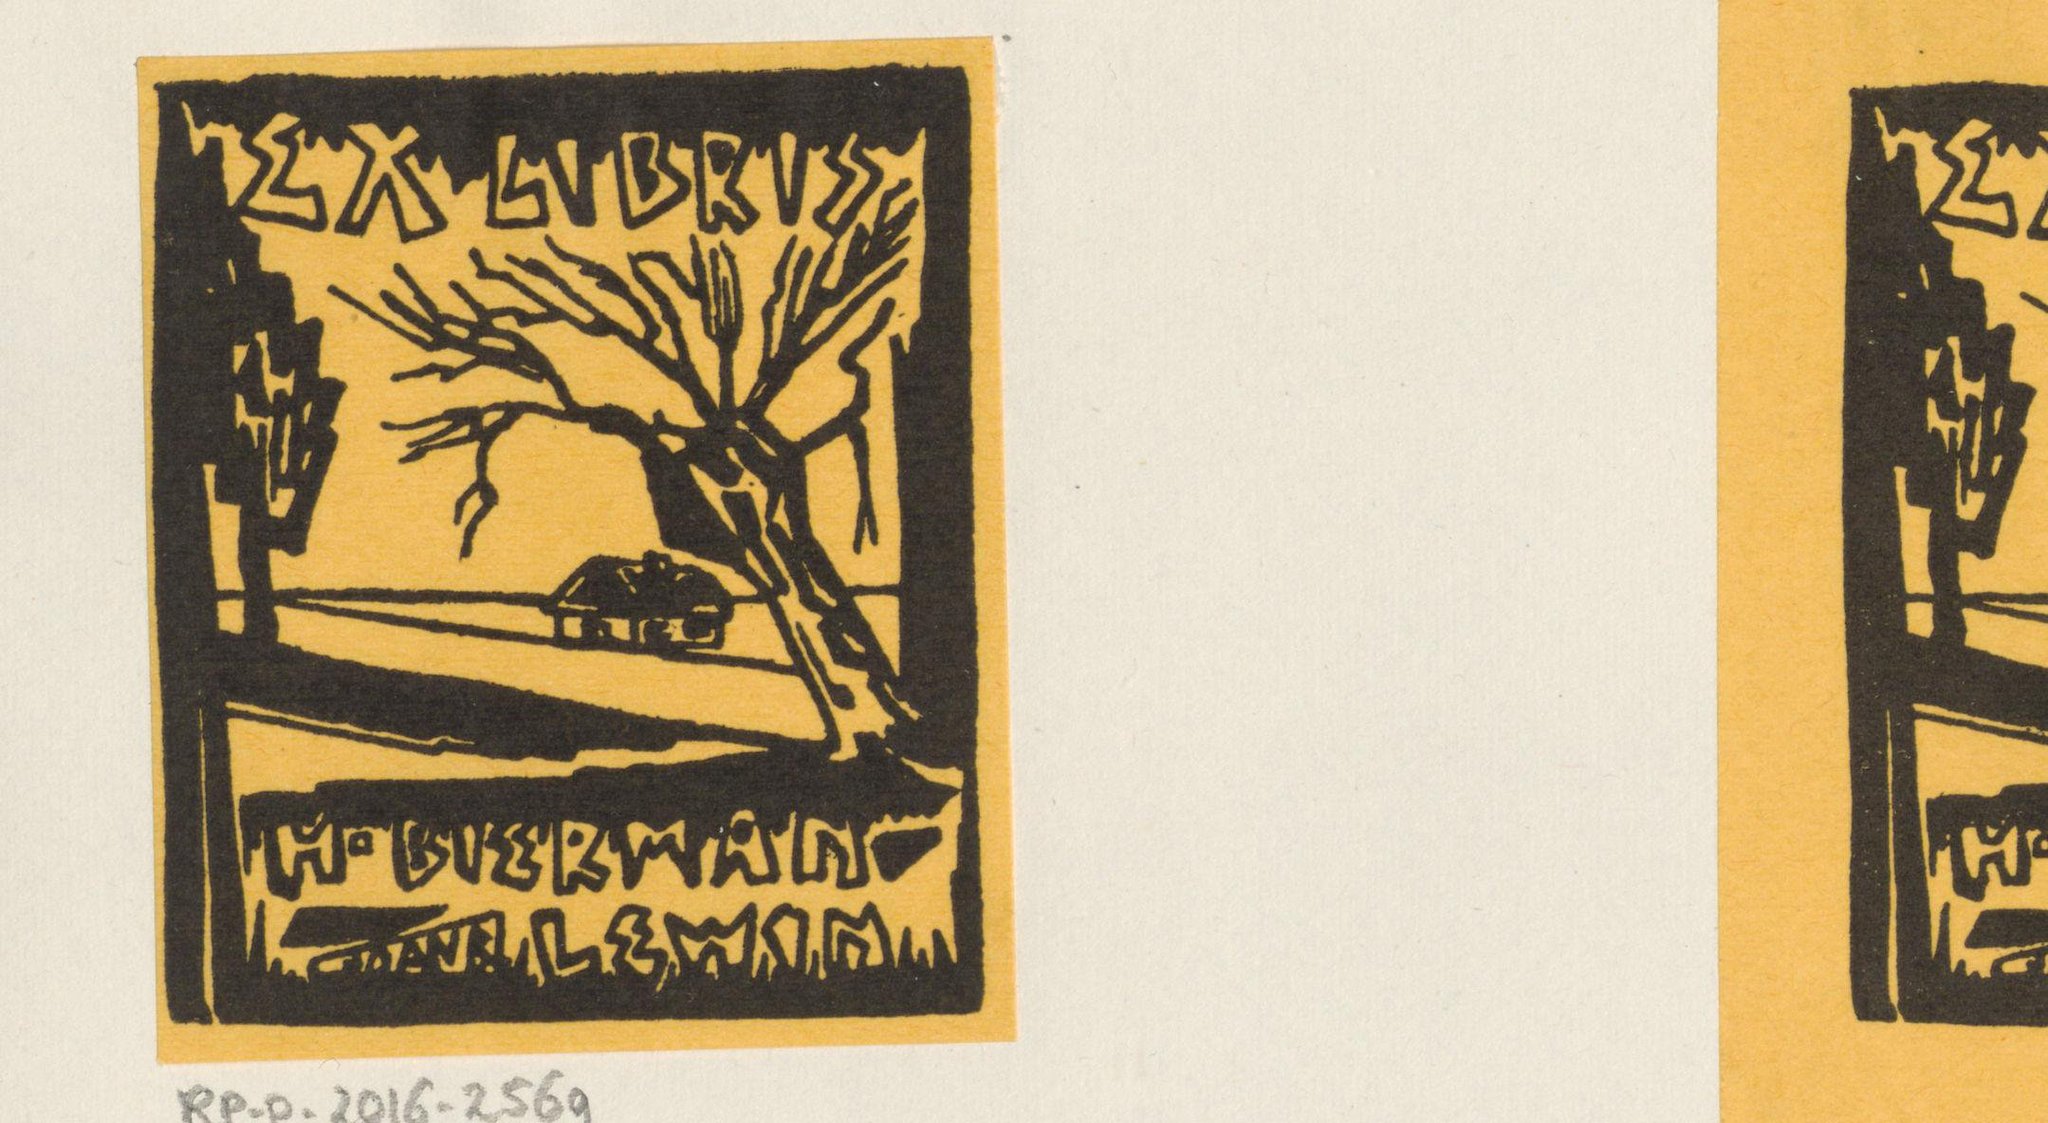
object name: bookplate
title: Ex libris van H. Bierman-Lewin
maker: joan bierman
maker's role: print maker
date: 1900-1999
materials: paper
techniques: printing block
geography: netherlands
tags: meadow, pasture, trees: willow